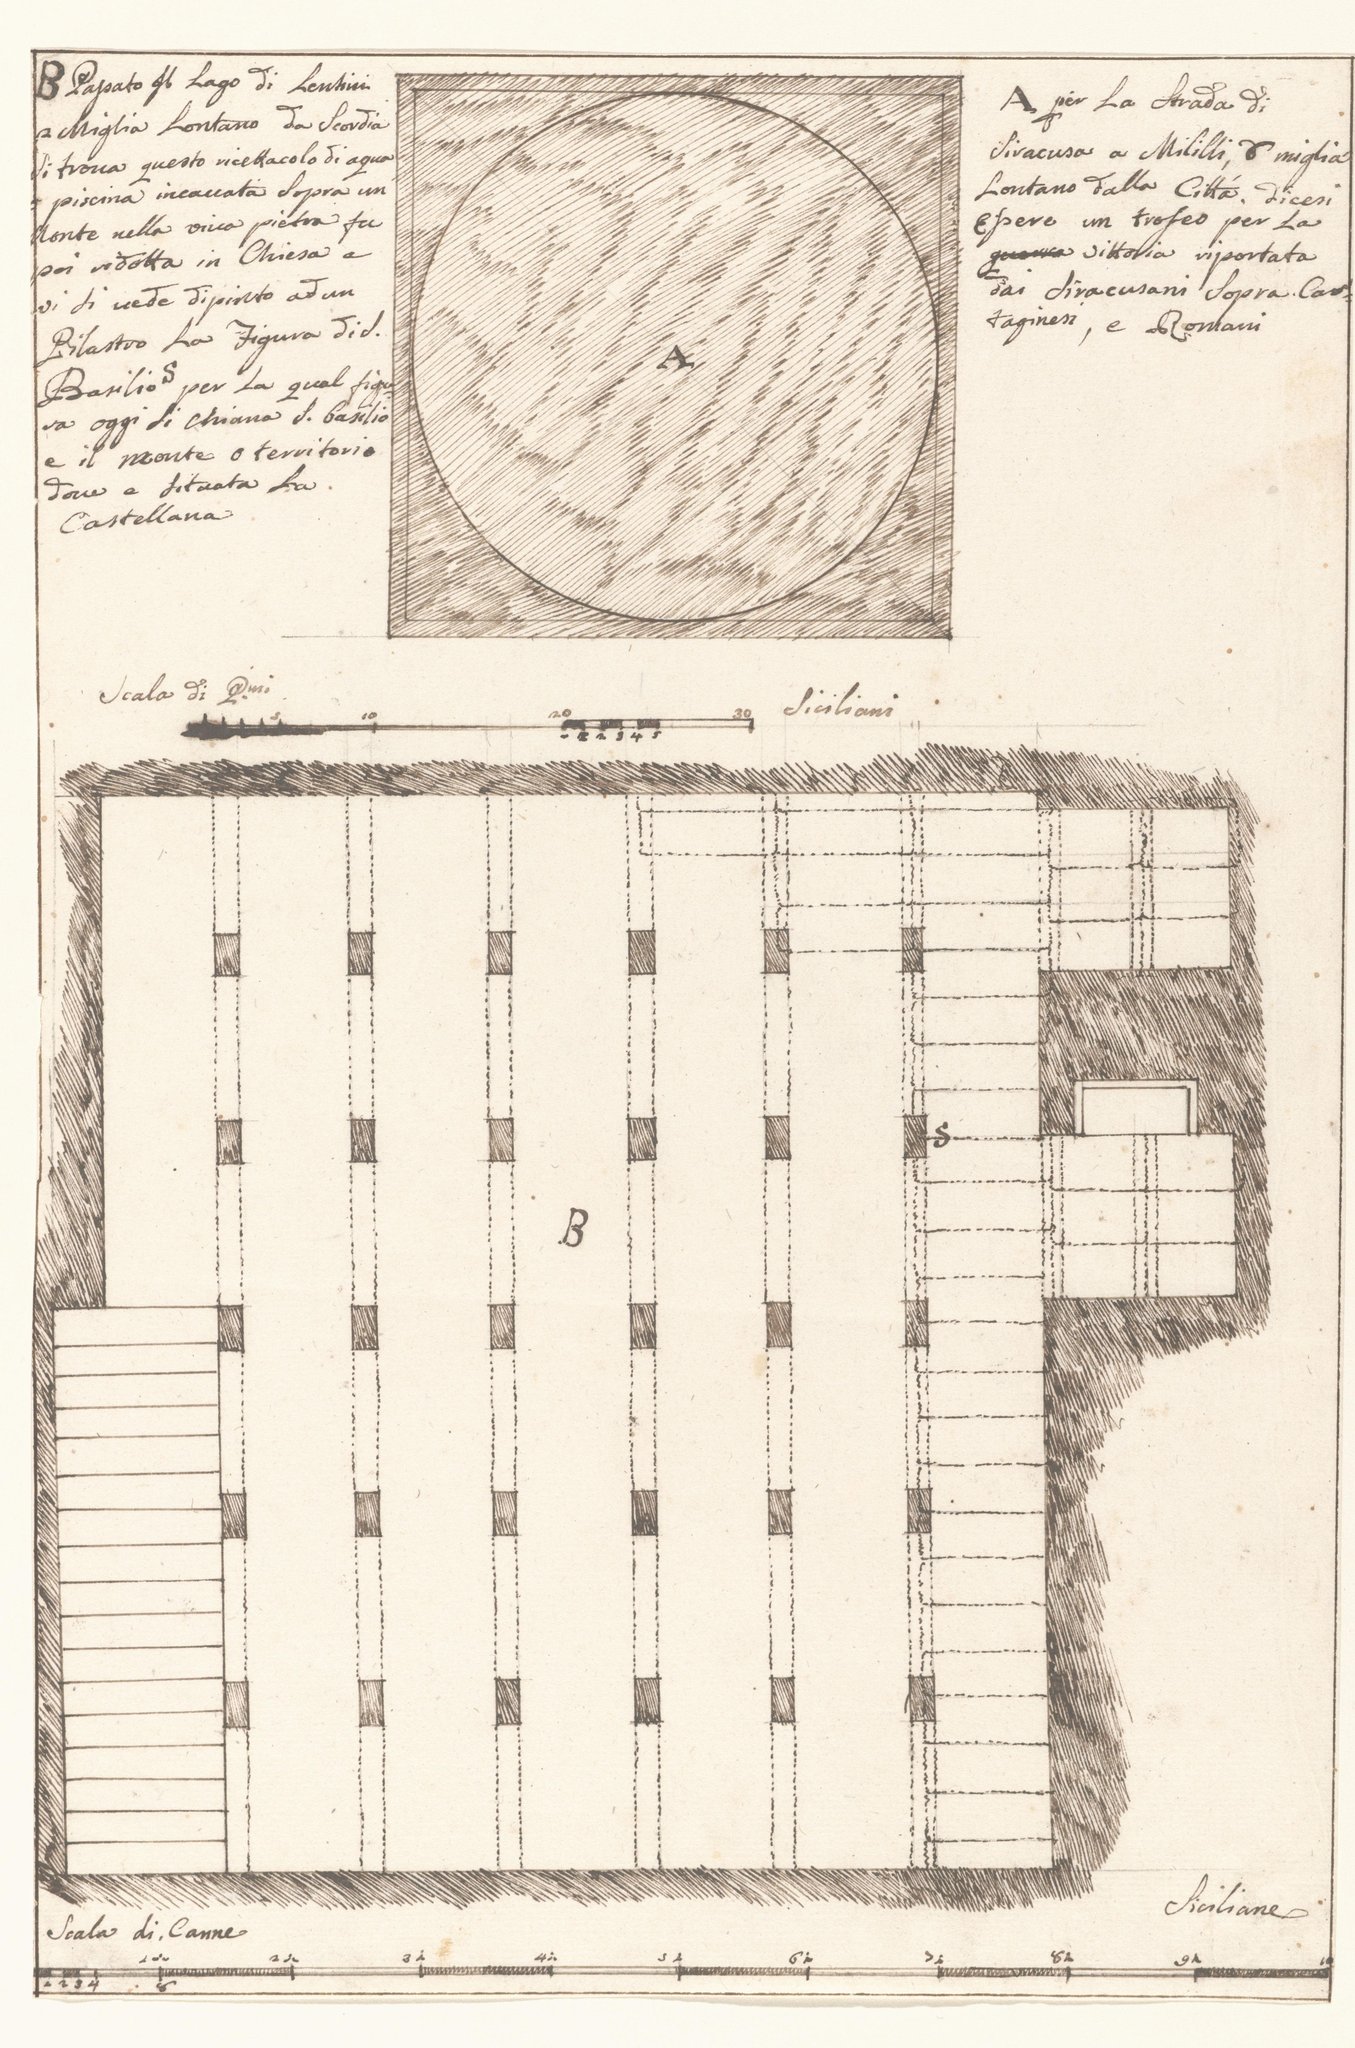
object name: drawing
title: Plattegrond van waterreservoir in omgeving van Lac de Lentini en ruïne van gedenkteken 6 mijl van Syracuse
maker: louis mayer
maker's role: draughtsman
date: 1778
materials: paper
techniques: pen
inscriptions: inscription: ‘A per la Strada di Siracusa ...taginesi e Romani’, inscription: ‘B Passato di Lago di Lentini ... situata la Castellana’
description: Tekening uit het album 'Voyage en Italie, en Sicile et à Malte', 1778.